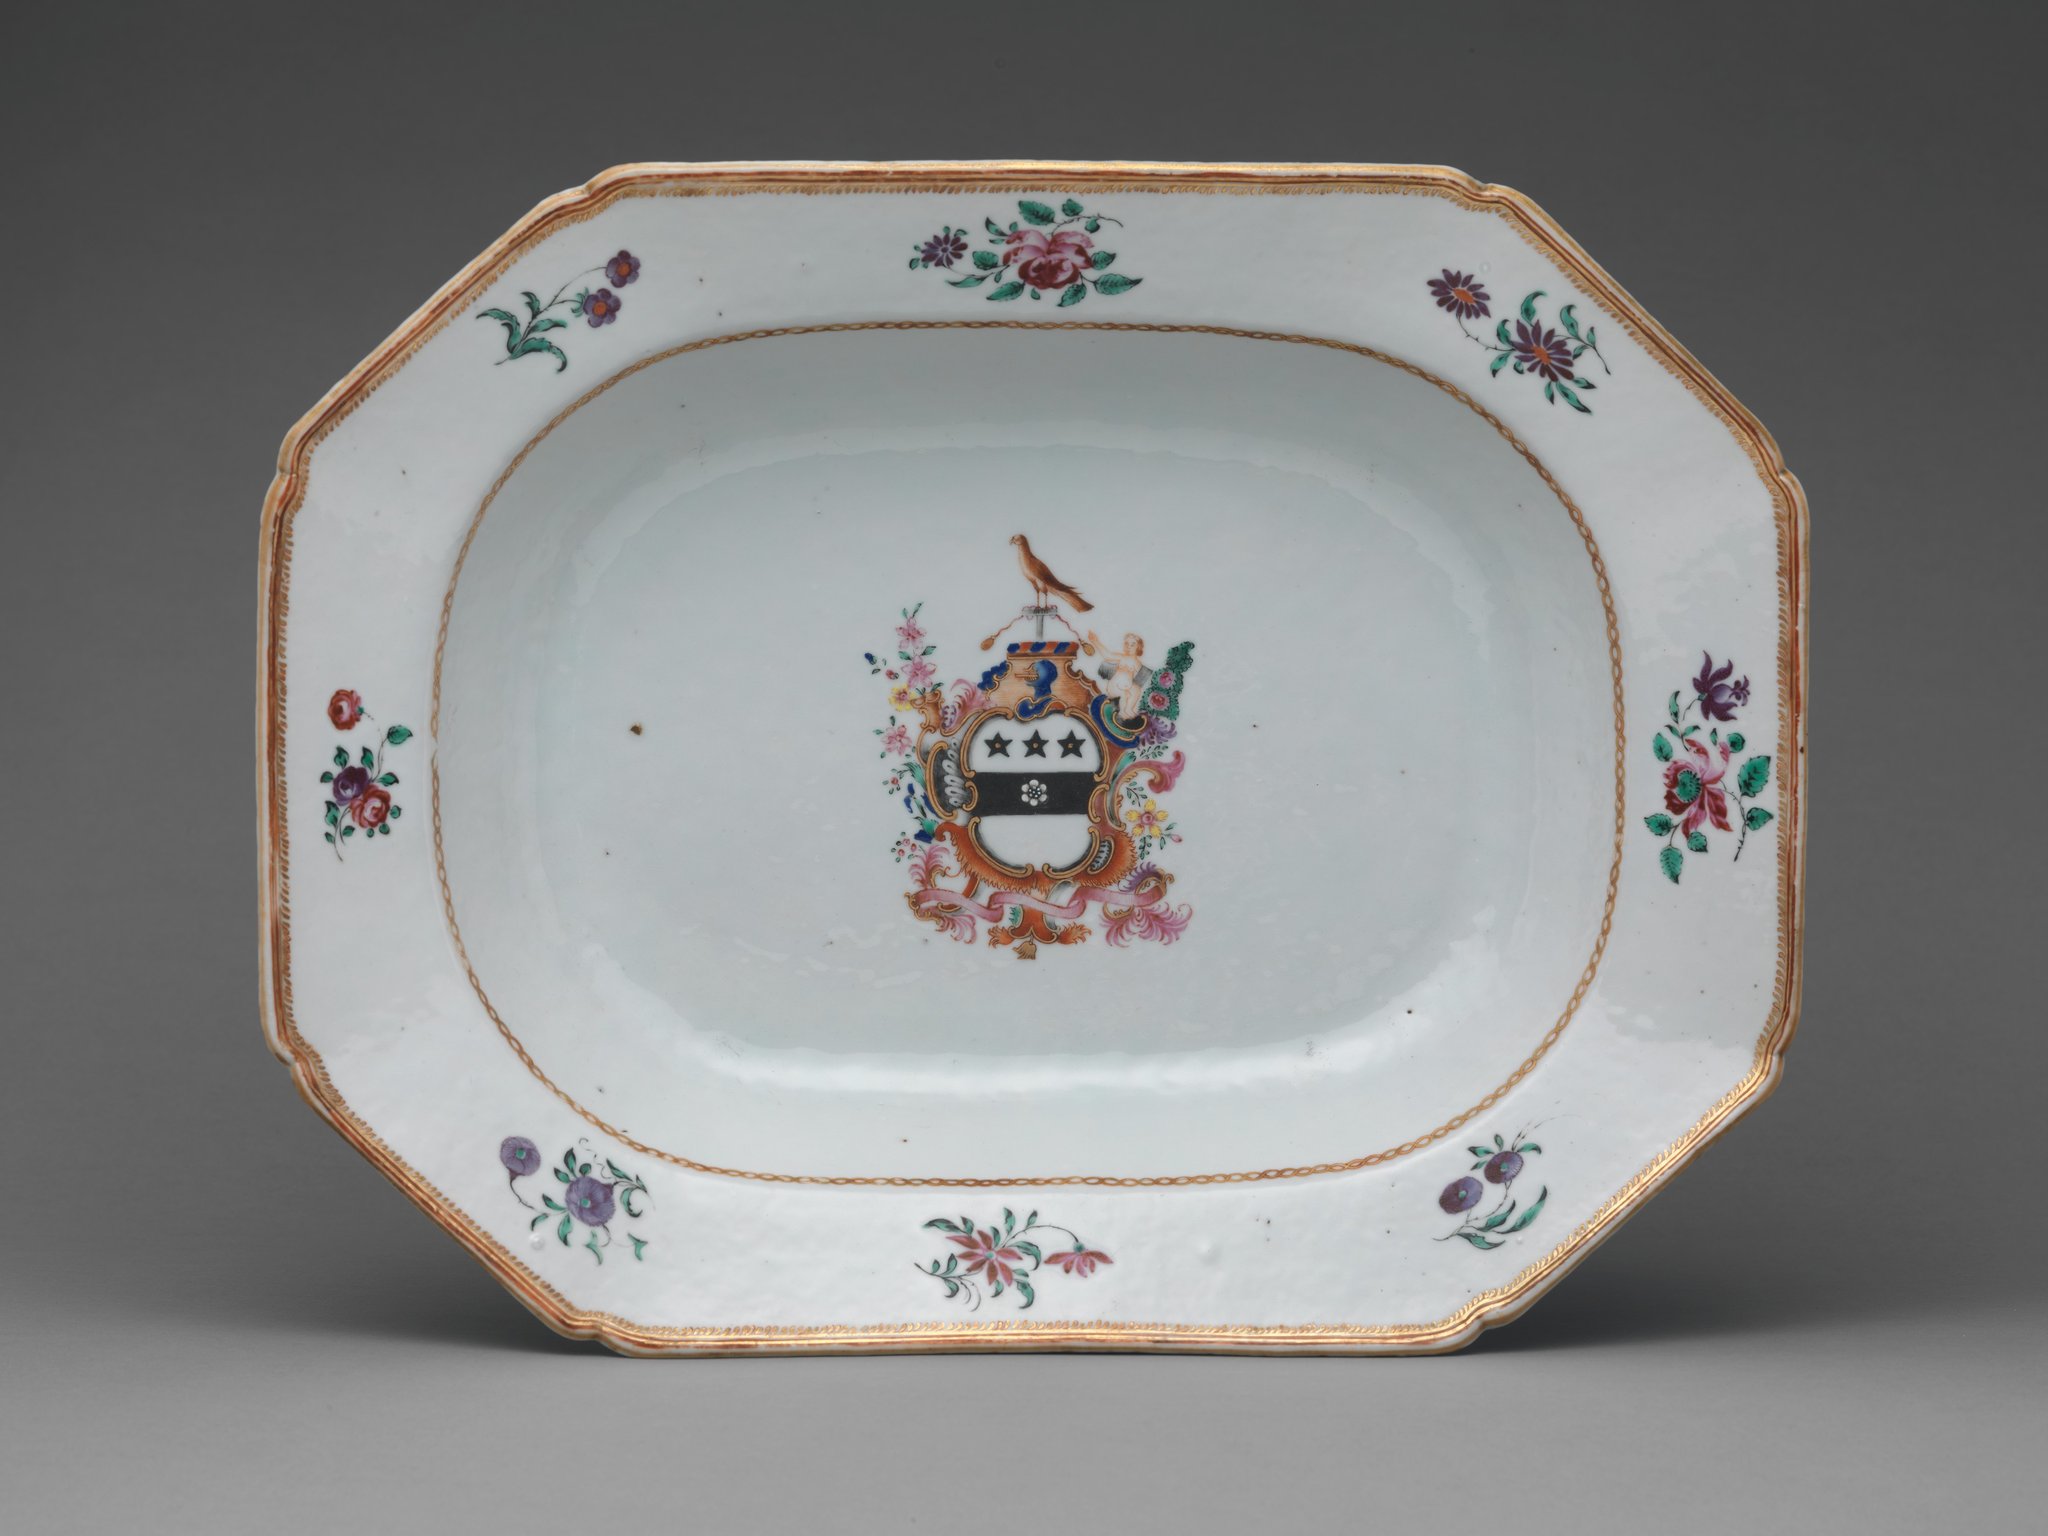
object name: platter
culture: chinese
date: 1785-1790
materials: porcelain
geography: china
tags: birds,flowers,coat of arms